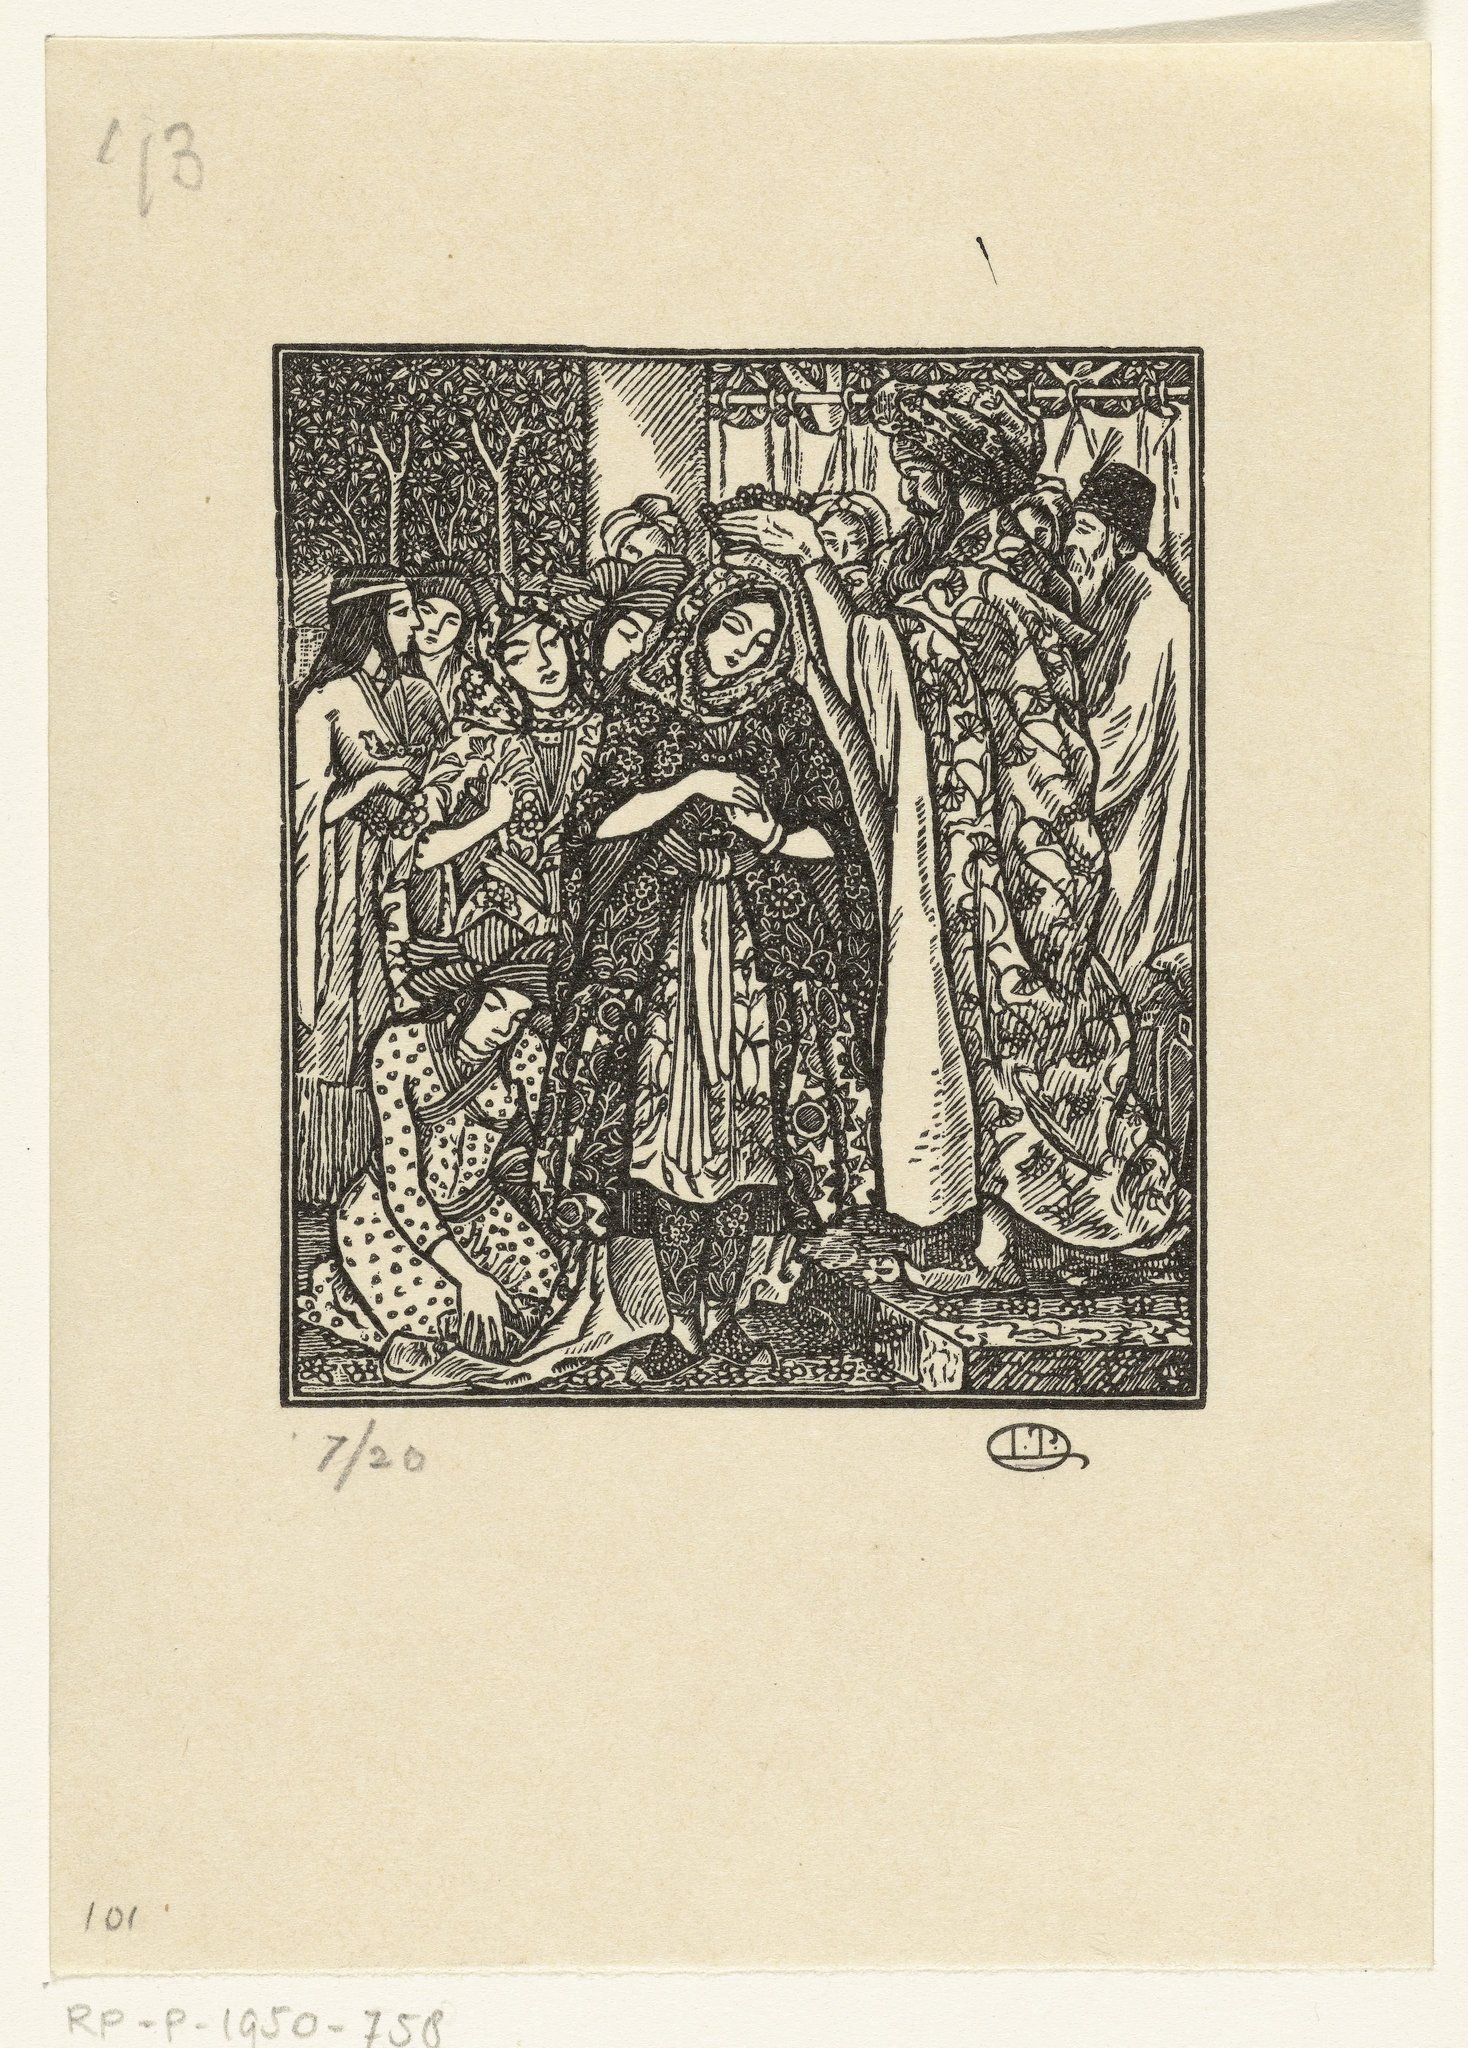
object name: print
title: De kroning van Esther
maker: lucien pissarro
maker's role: painter, print maker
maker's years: 1863-1944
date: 1896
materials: paper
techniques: engraving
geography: hammersmith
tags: crowning of esther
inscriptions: stamp: Lugt 1756b, collector's mark: Lugt 2228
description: De houtgravure is gemaakt als boekillustratie voor "The book of Ruth and the book of Esther", gedrukt bij Eragny (de drukkerij van Lucien Pissarro en zijn vrouw) in 1896 en verkoocht bij Hacon en Ricketts. K.Botke